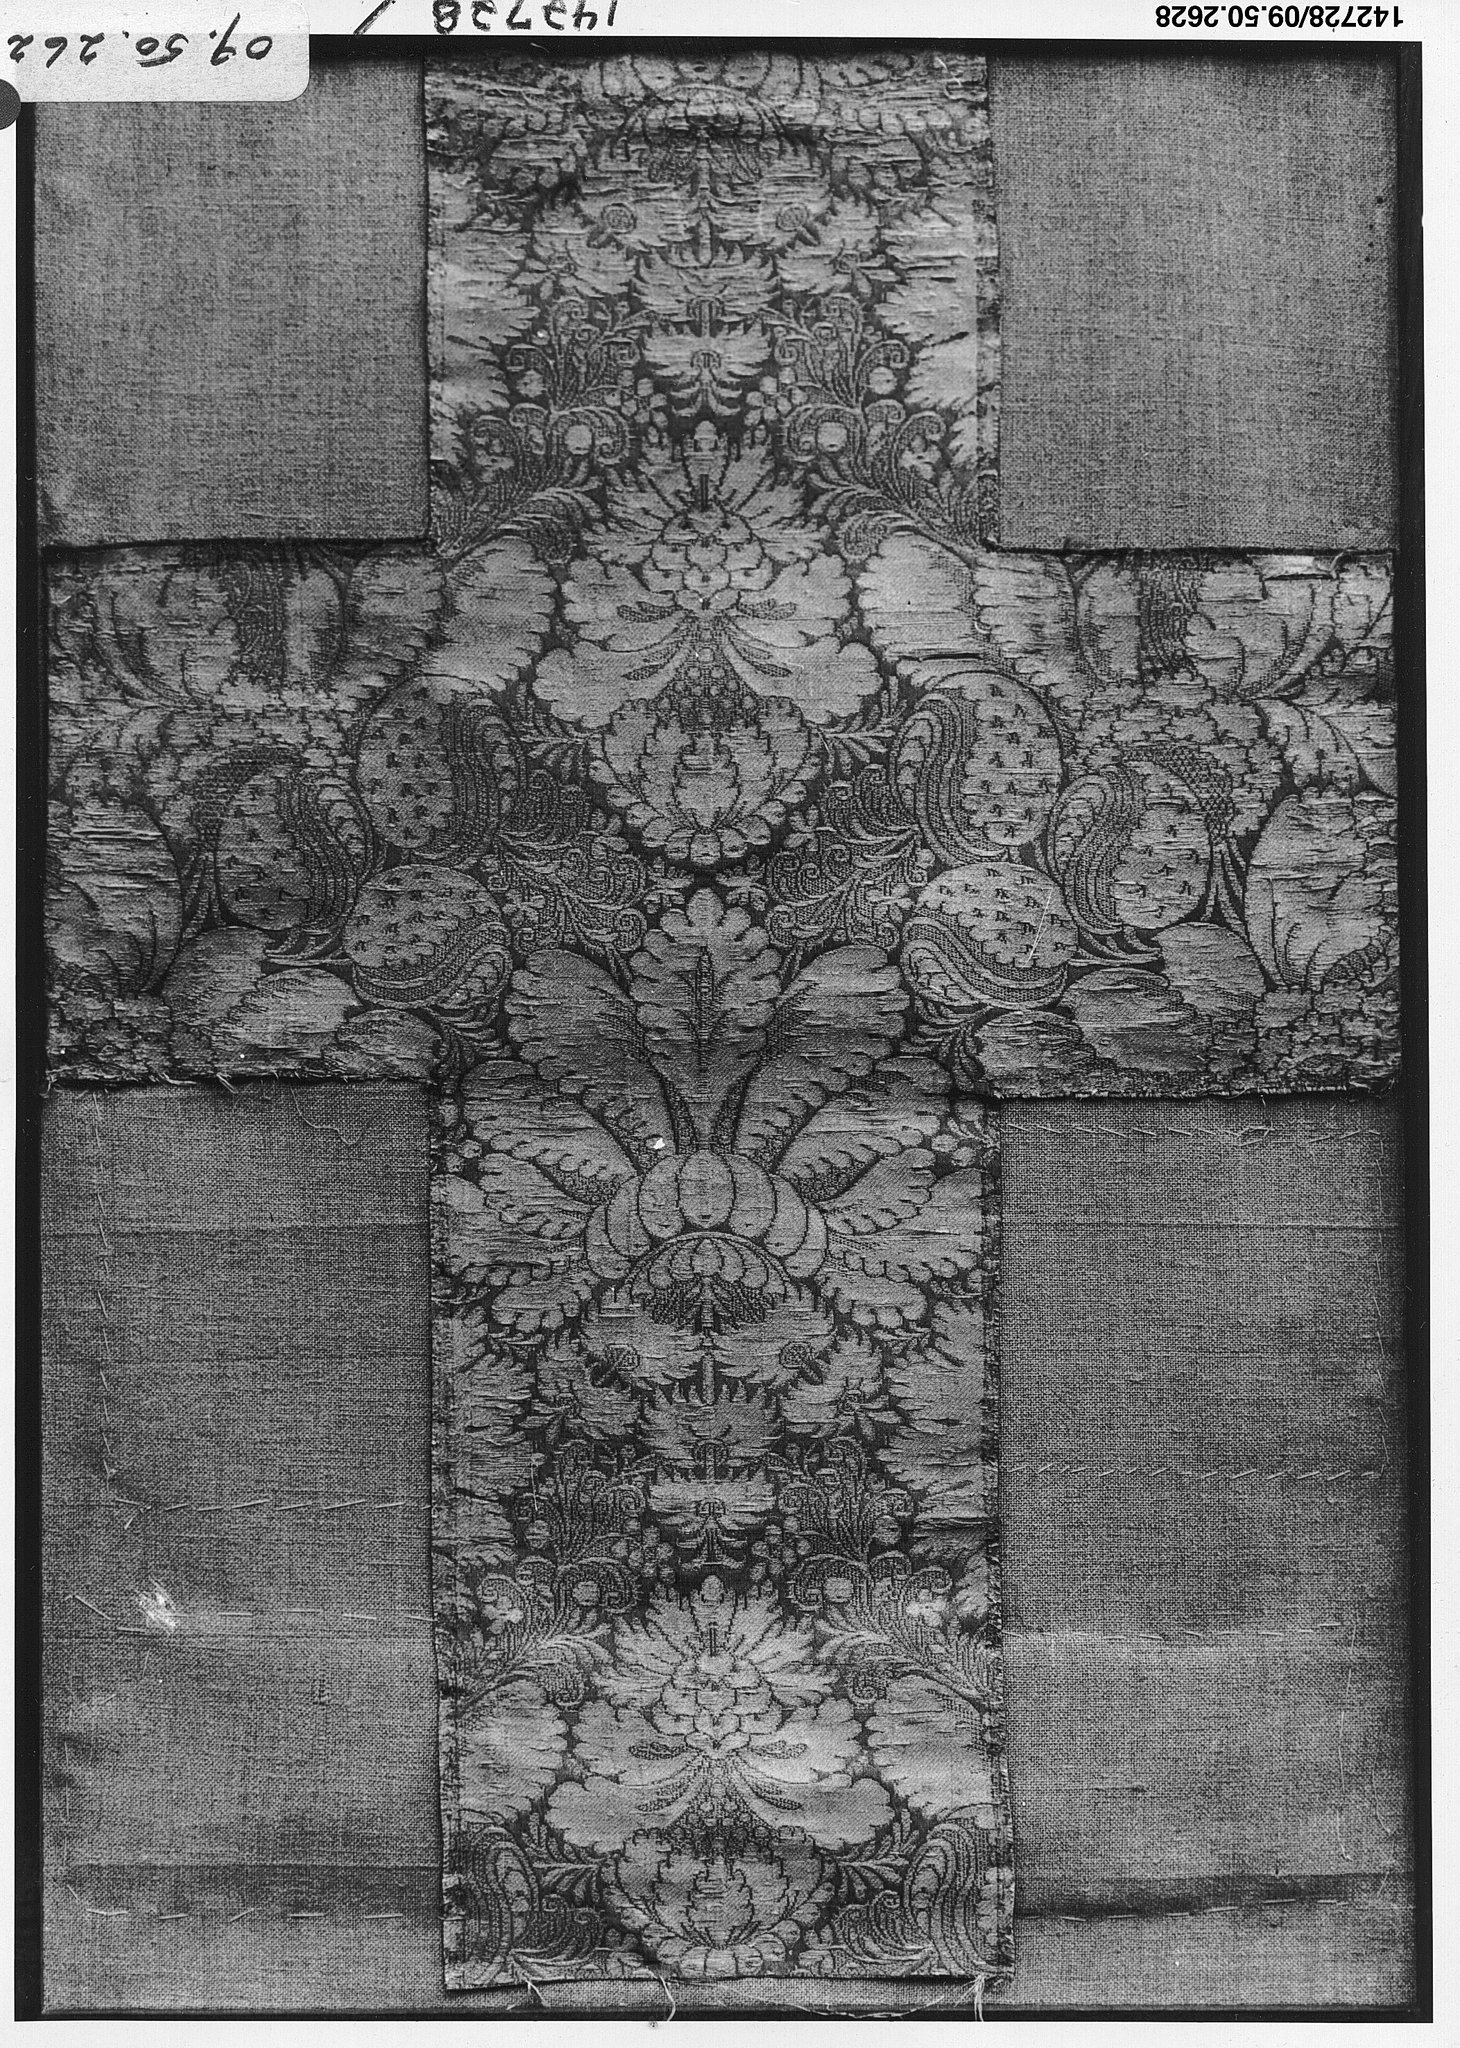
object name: orphrey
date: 1667-1700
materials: metal thread, silk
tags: flowers